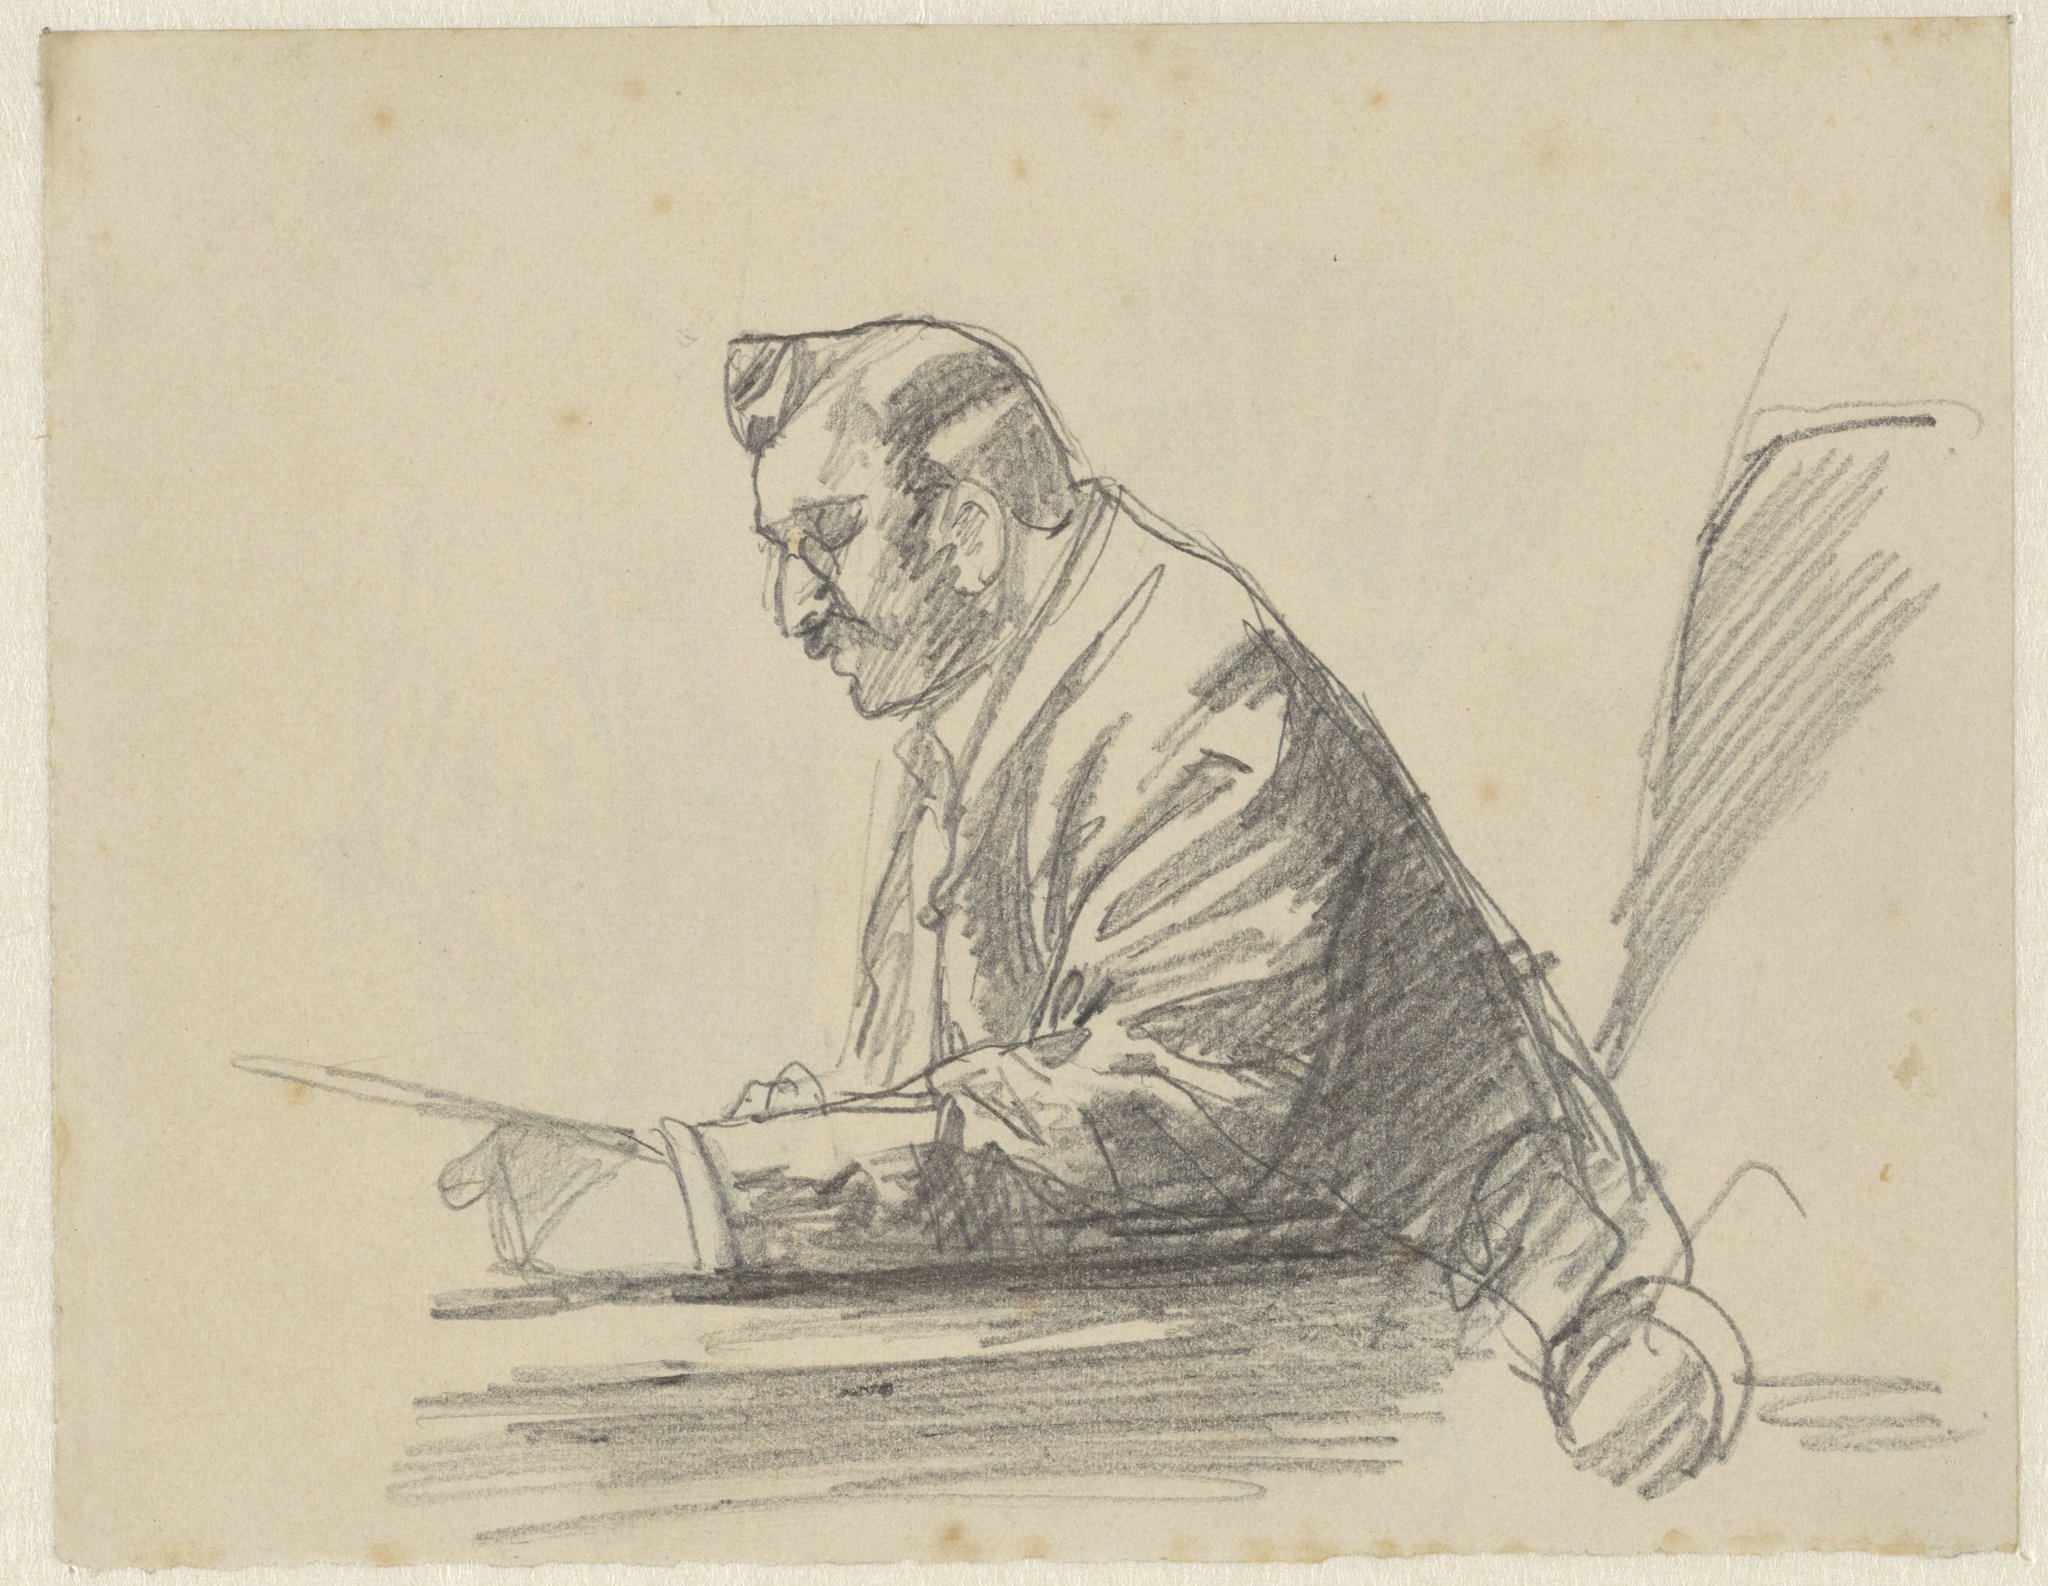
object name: drawing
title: Zittende lezende man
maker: jac van looij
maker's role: draughtsman, painter, print maker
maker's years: 1855-1930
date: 1865-1930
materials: paper, pencil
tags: reading